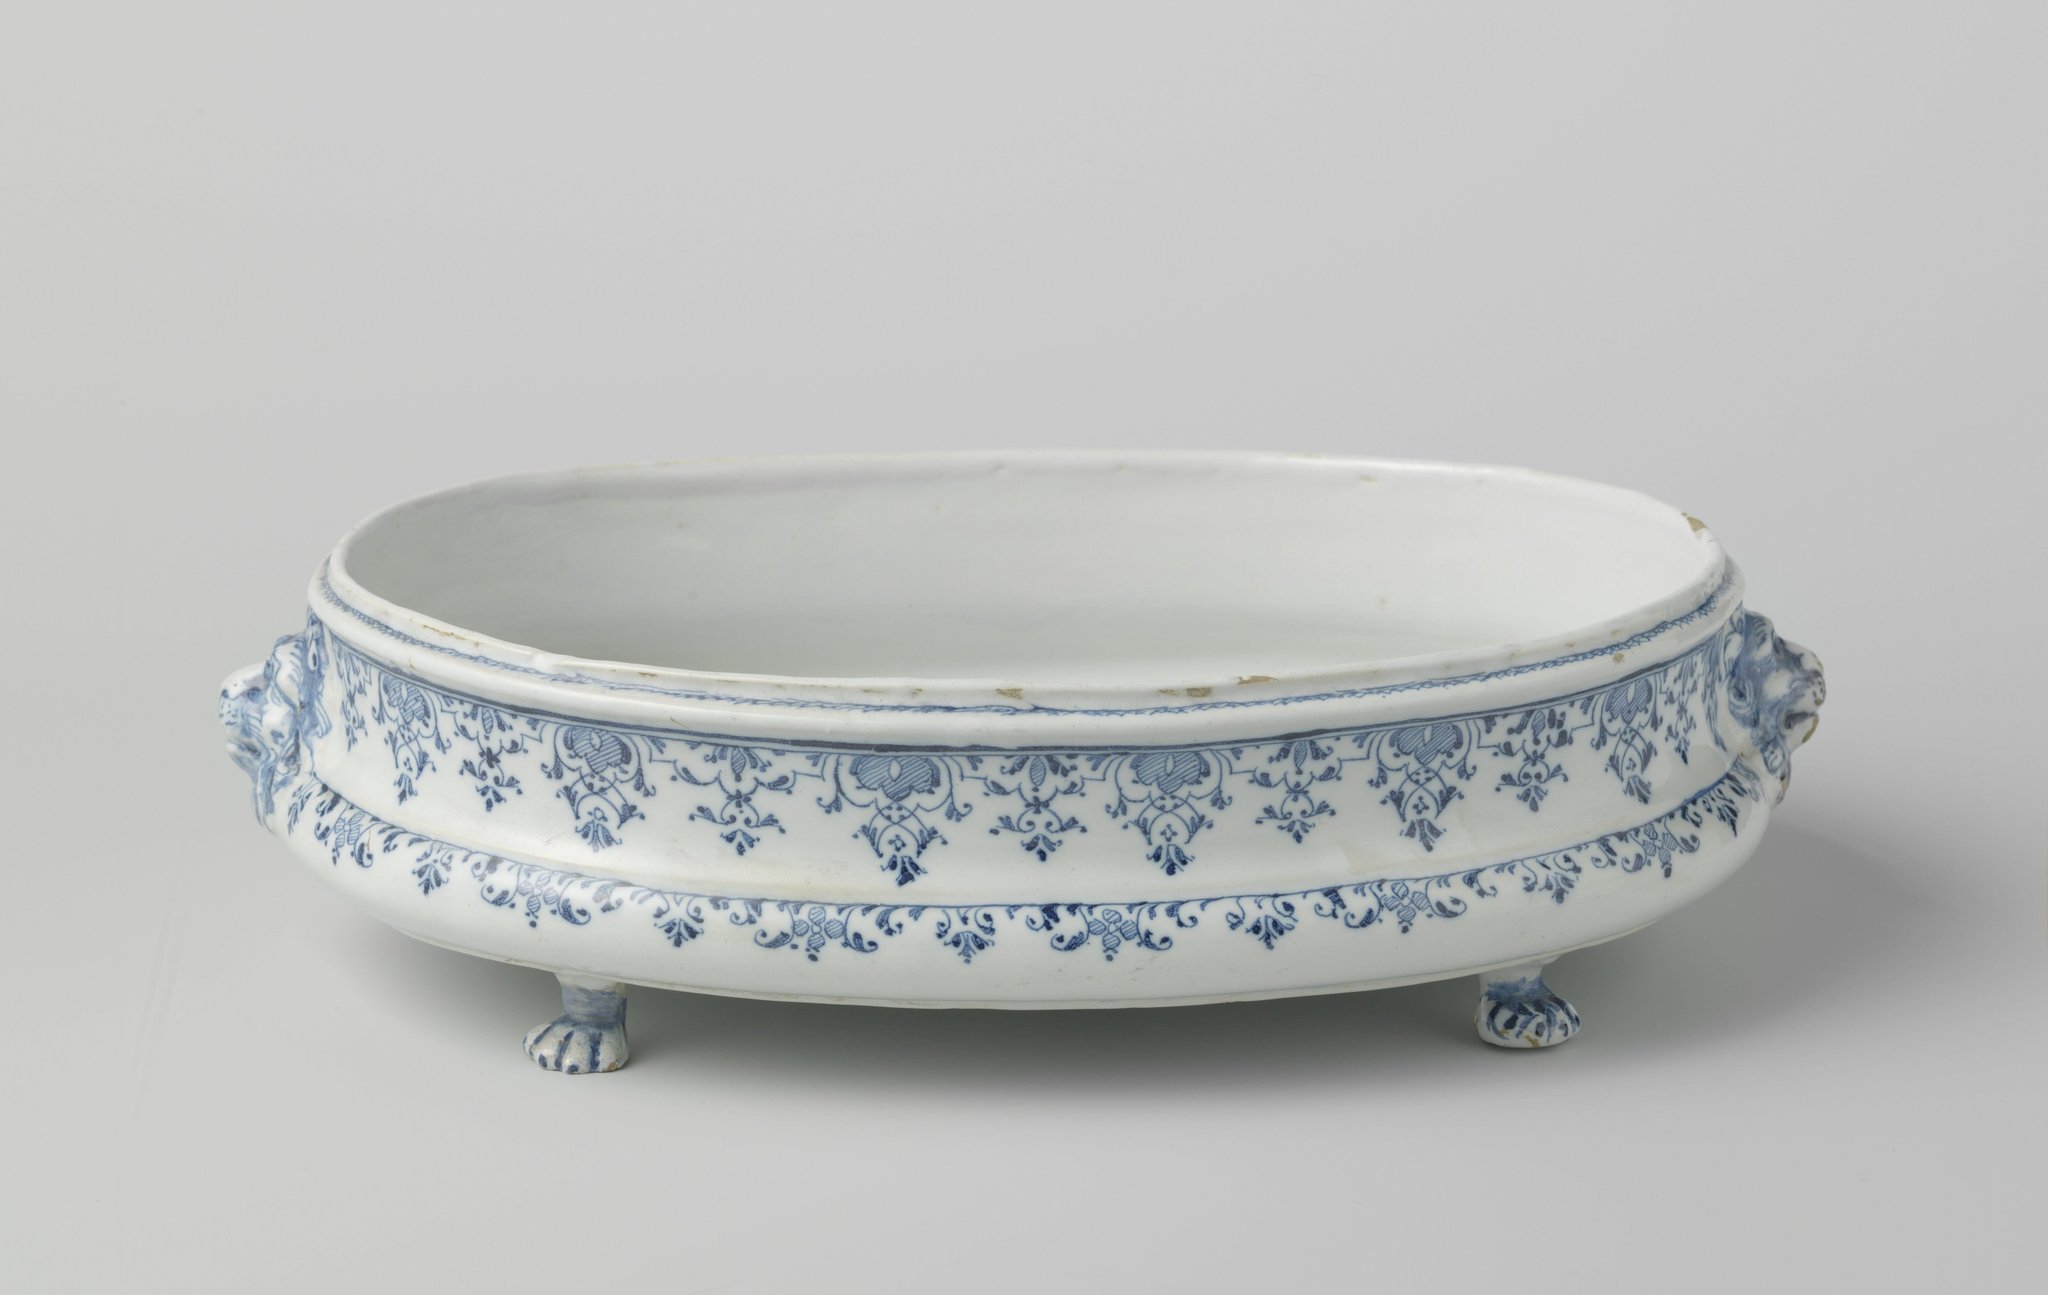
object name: bowl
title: Kom op vier poten, beschilderd met bloem- en bladranken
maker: pierre clérissy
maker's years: 1651-1728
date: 1700-1730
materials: faience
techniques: painted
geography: moustiers-sainte-marie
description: Bowl, faience with grand feu decoration. Moustiers (France), c. 1700 - 1730, factory of Pierre Clérissy.